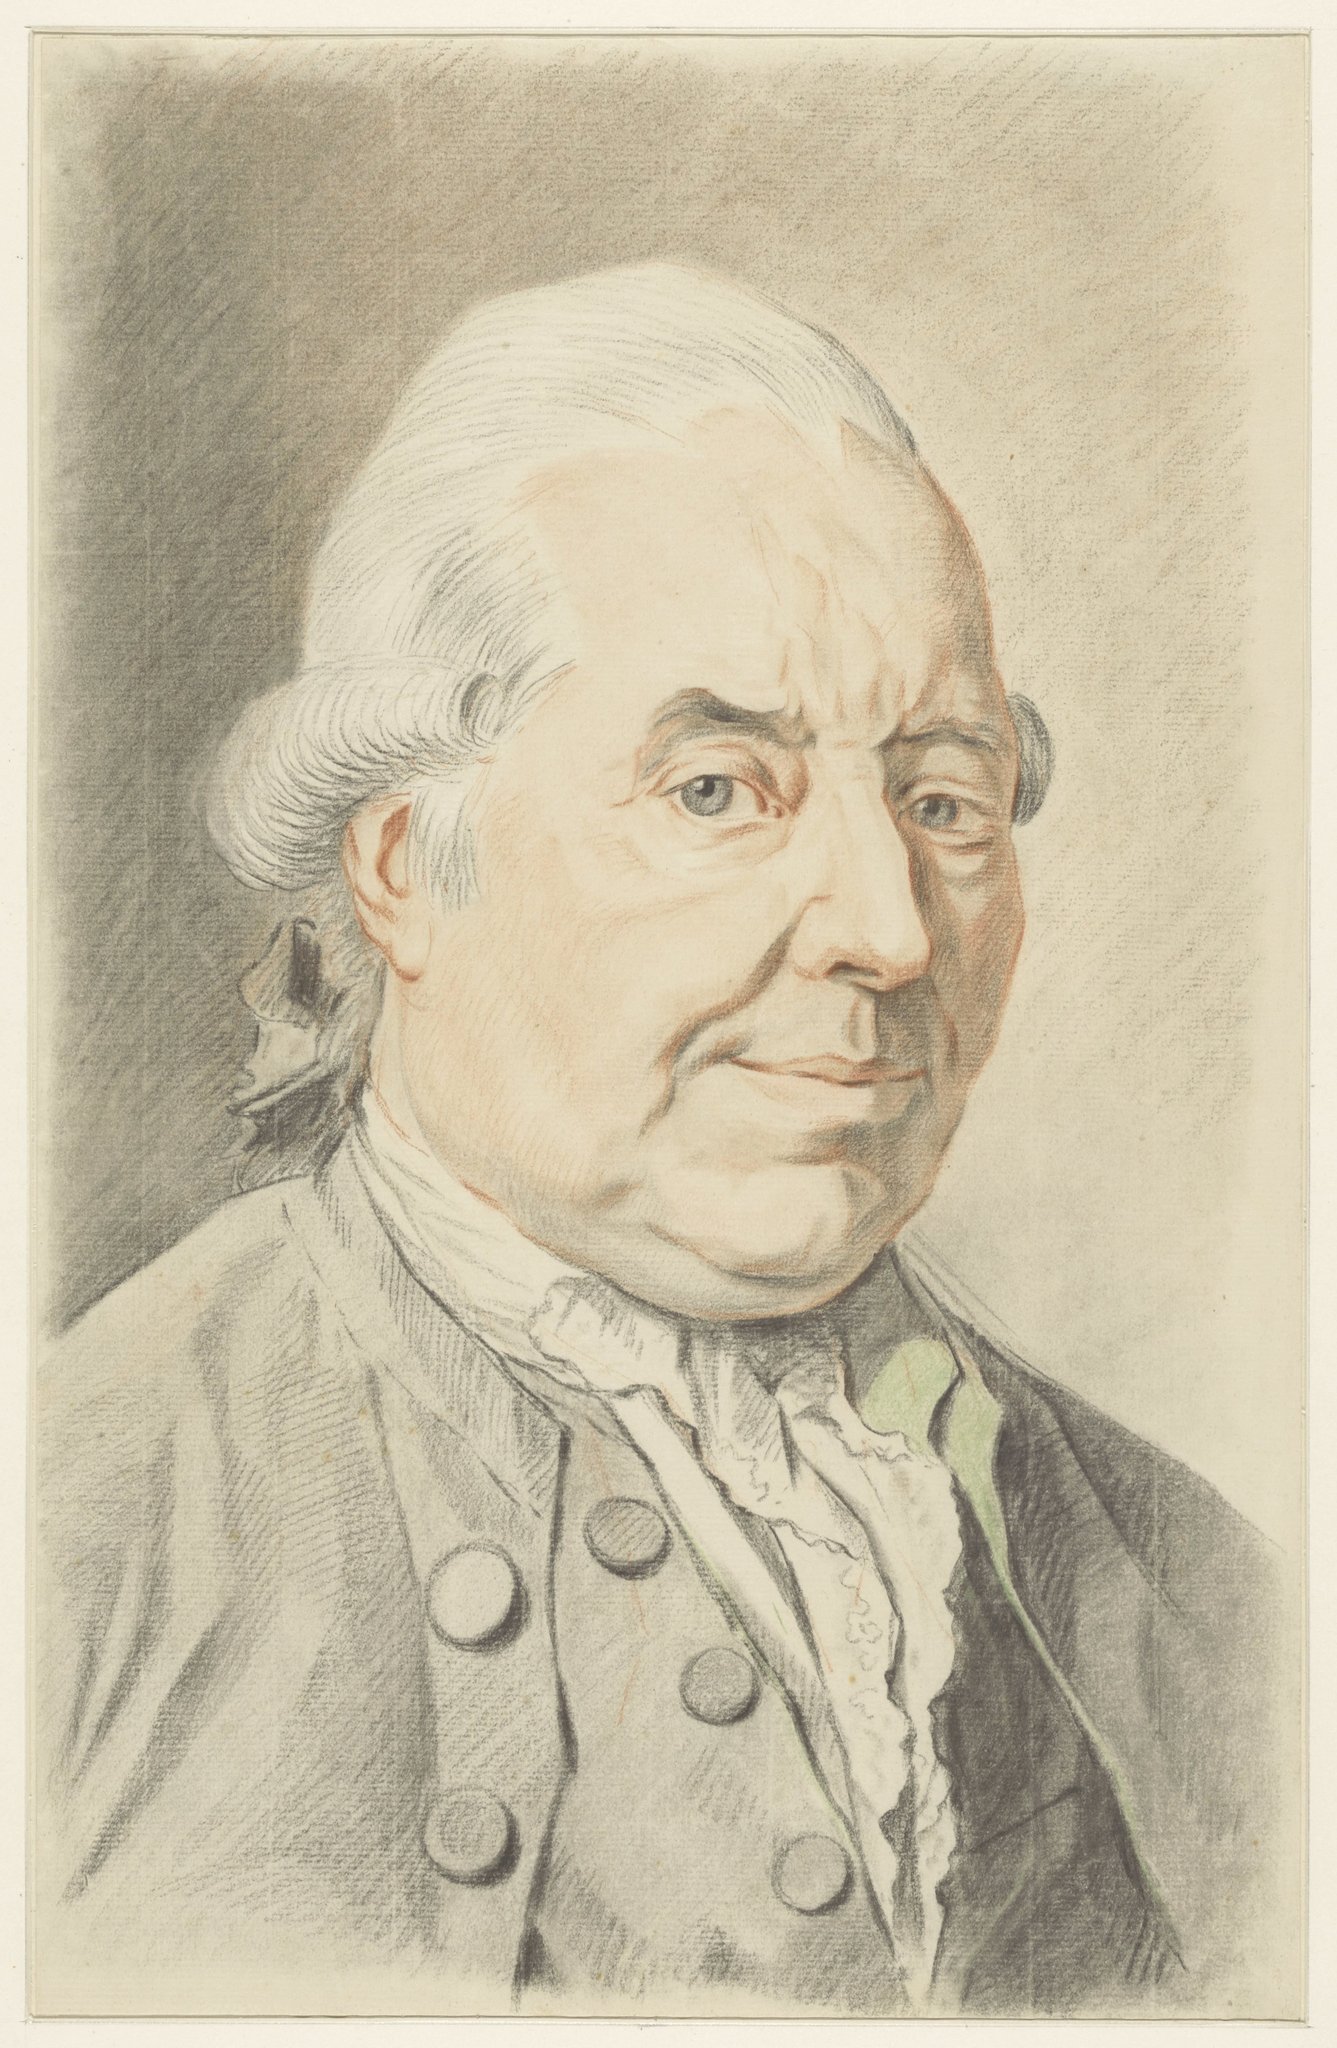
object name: drawing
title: Zelfportret van Jacob Perkois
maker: jacob perkois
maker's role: draughtsman, print maker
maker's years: 1756-1804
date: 1766-1804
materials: chalk, paper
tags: middelburg, print maker, draughtsman, jacob perkois, historical persons, portrait, self-portrait of artist